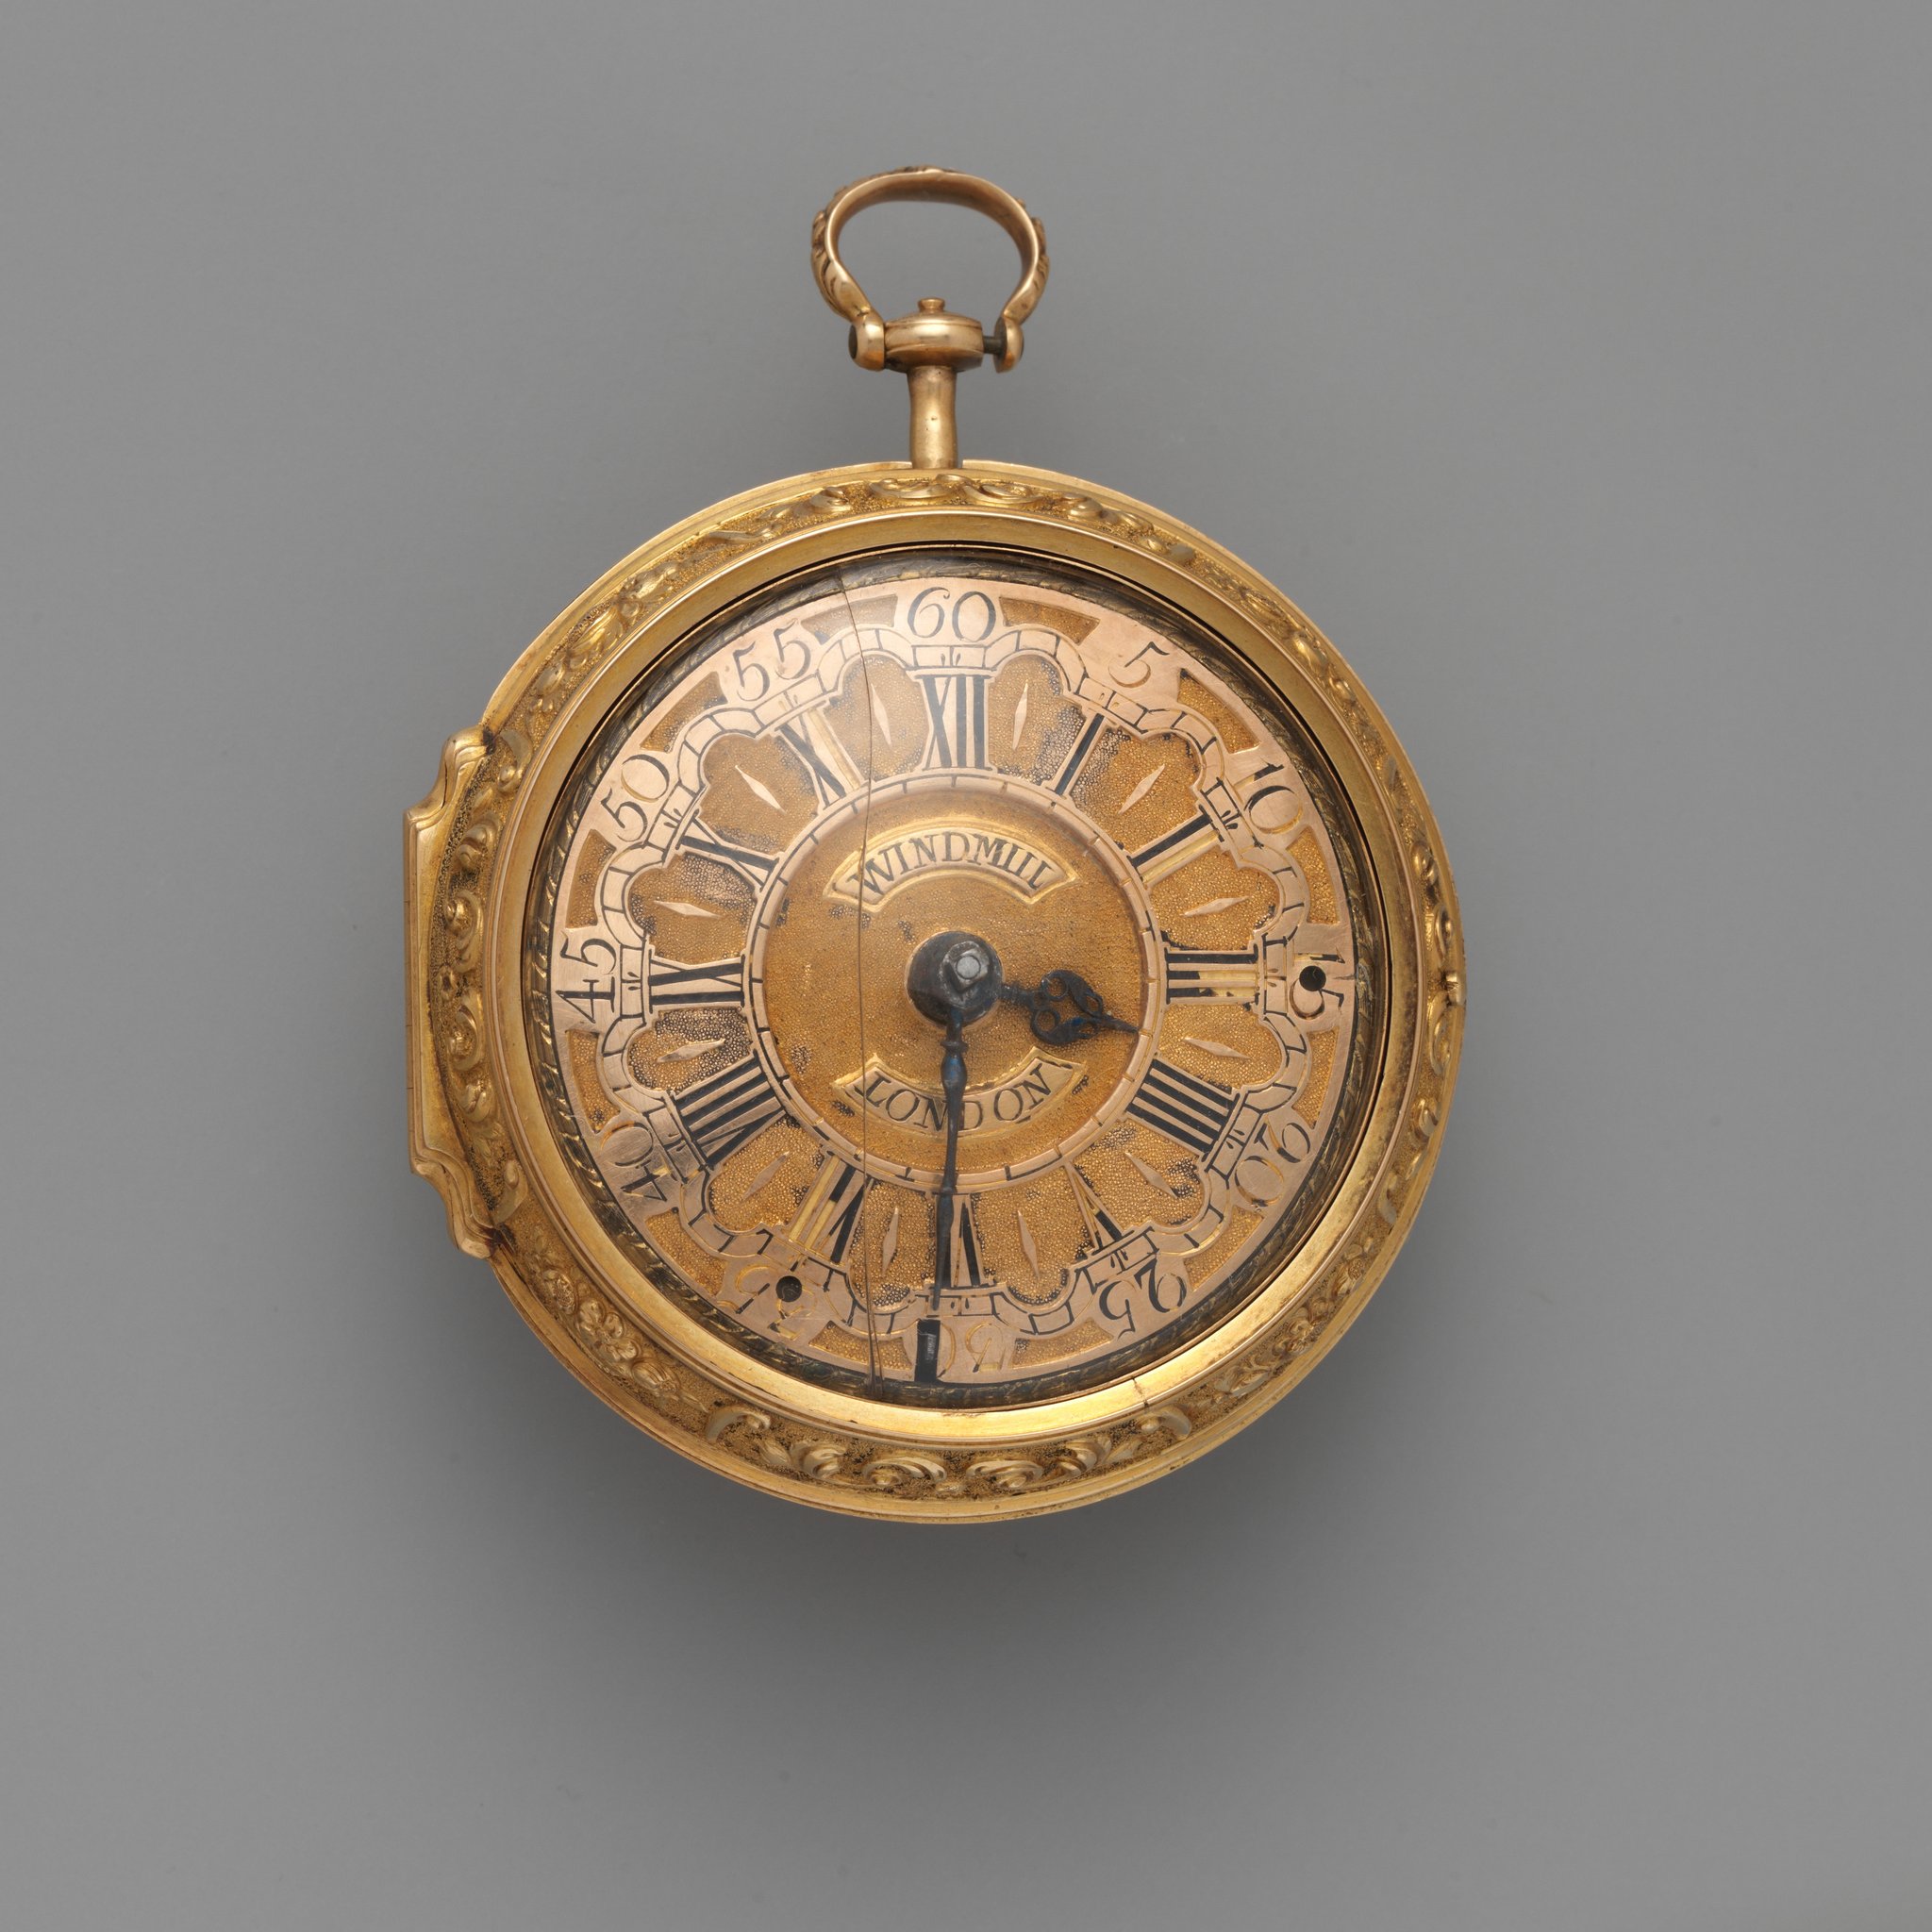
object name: pair case watch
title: Pair-case watch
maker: windmill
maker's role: maker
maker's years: 1675-1775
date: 1701-1733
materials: gold